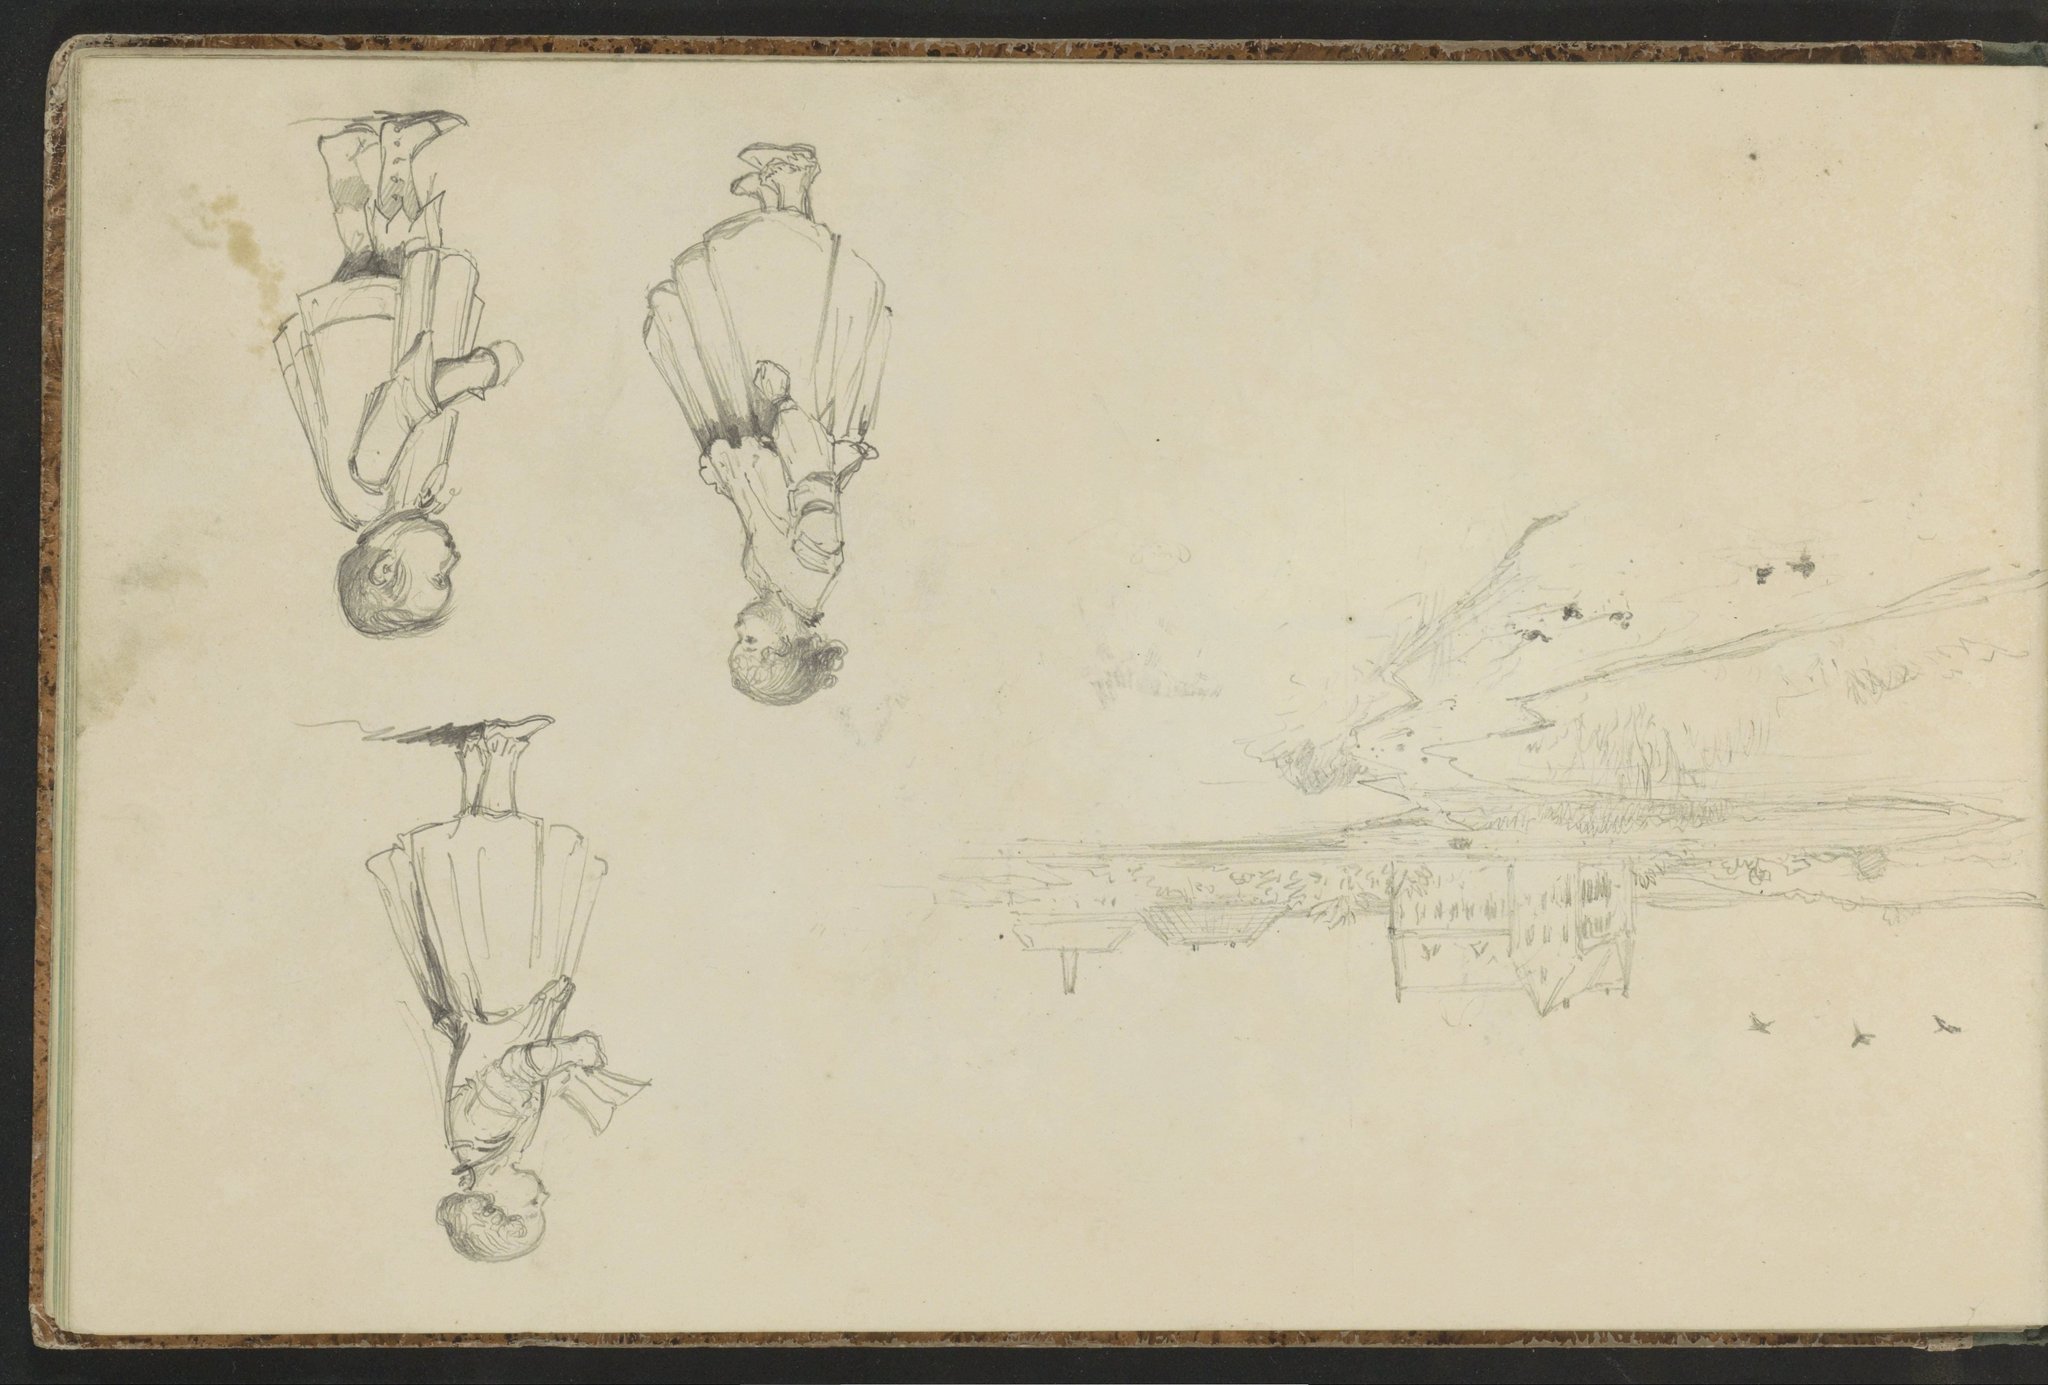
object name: sketchbook leaf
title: Gebouwen aan een meer en drie kinderen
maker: johannes tavenraat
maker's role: draughtsman, painter, print maker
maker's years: 1809-1881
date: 1840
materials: paper, pencil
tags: city-view, and landscape with man-made constructions, boy (child between toddler and youth), girl (child between toddler and youth), lake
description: Blad 13 verso uit een schetsboek met 33 bladen.